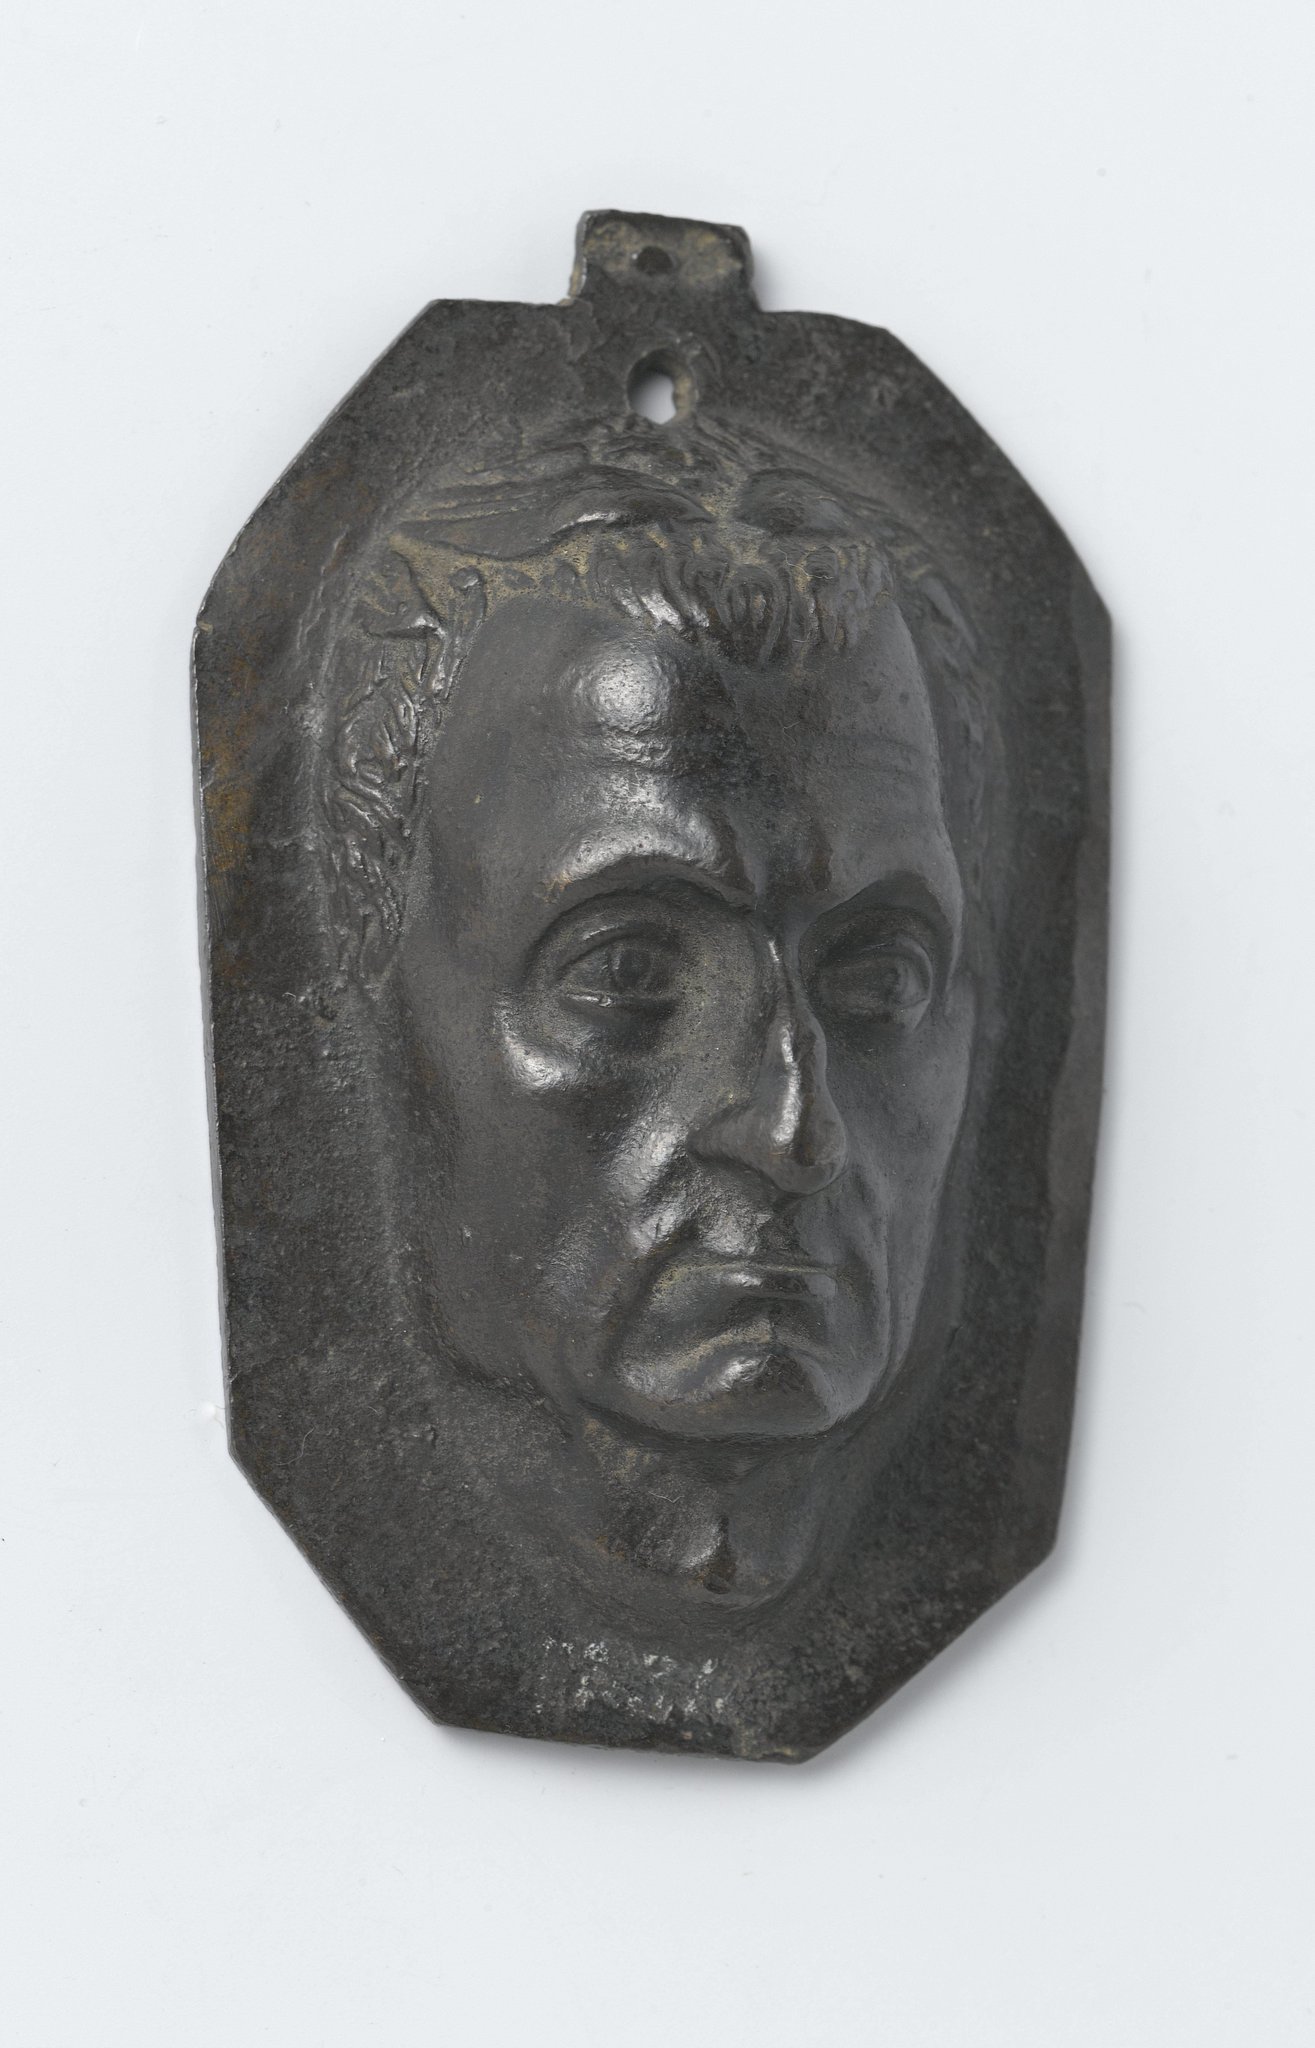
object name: sculpture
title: Mannenkop met lauwerkrans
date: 1550-1600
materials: bronze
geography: italy